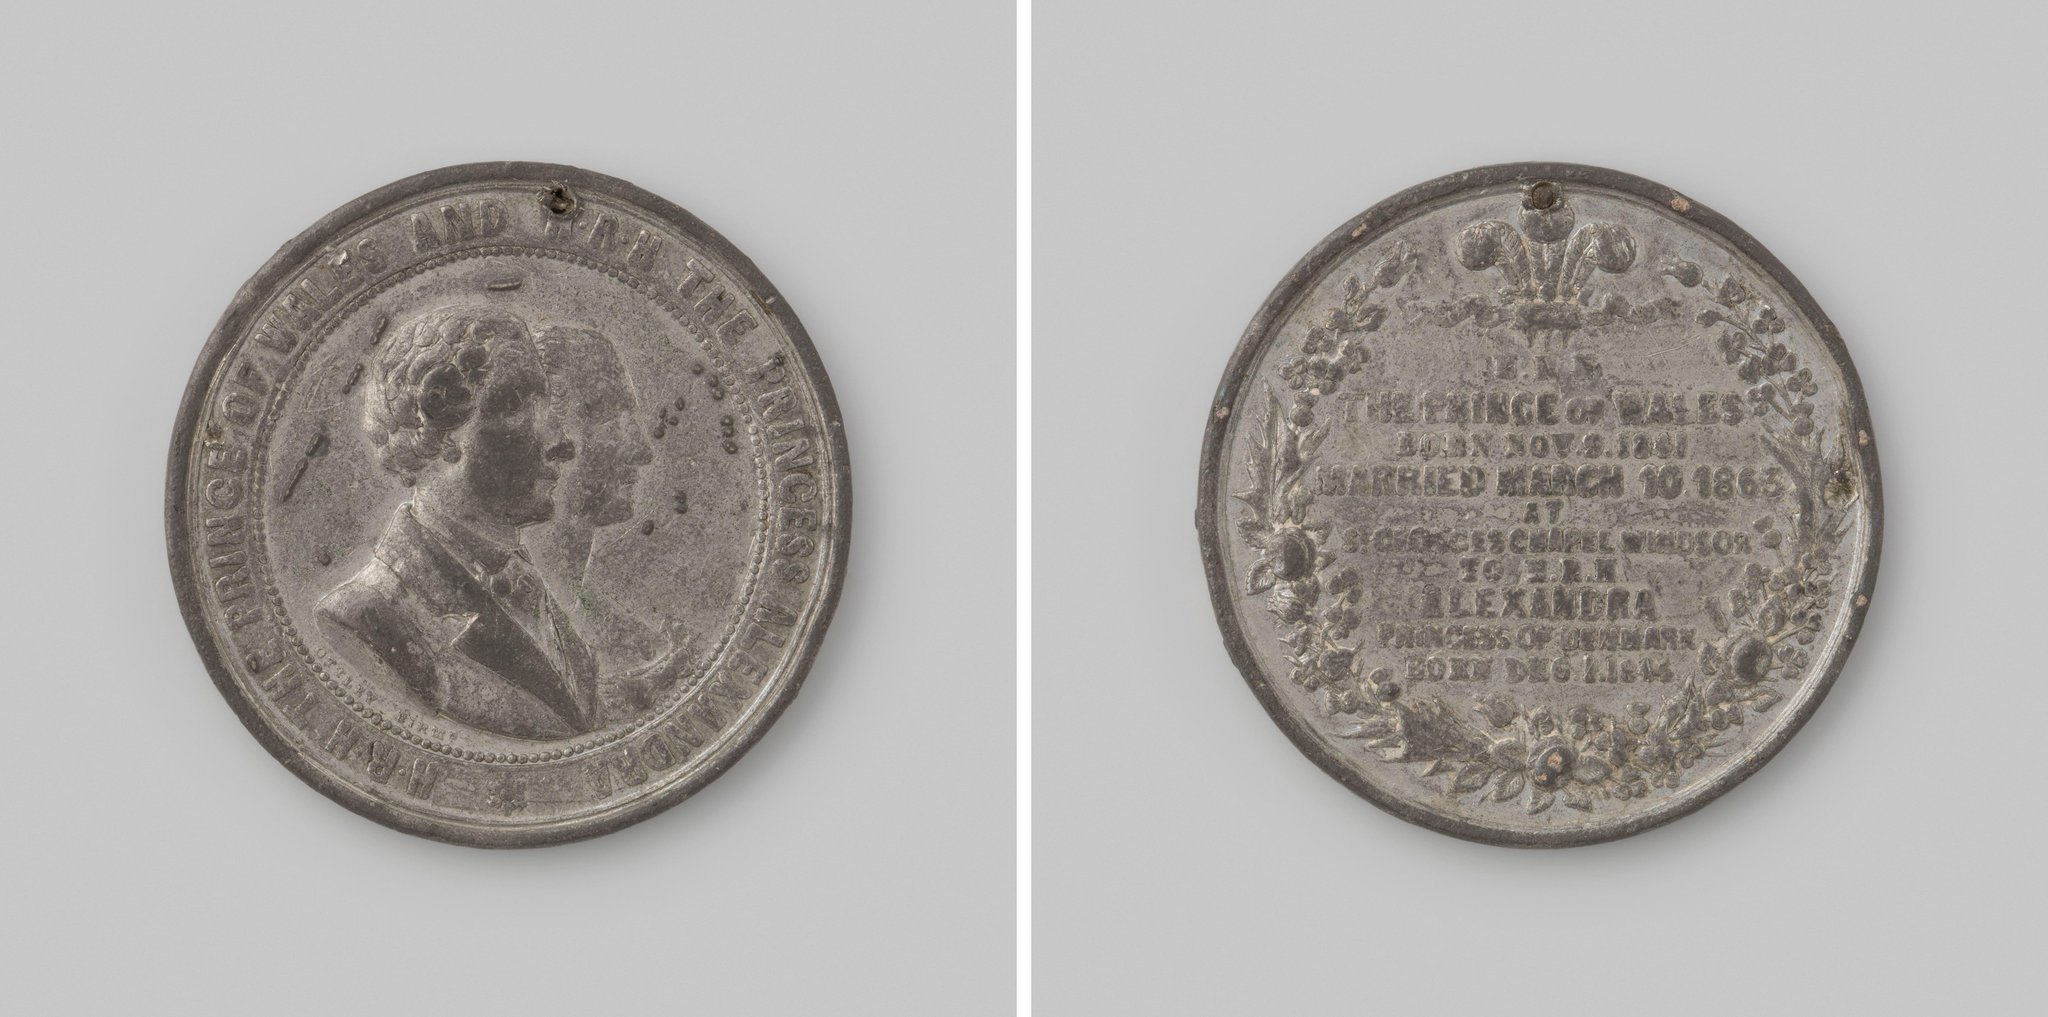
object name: history medal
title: Engelse penning op het huwelijk van de Prince of Wales met Alexandra van Denemarken 1863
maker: john ottley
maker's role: medailleur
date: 1863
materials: tin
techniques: striking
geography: birmingham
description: Tinnen penning met onvolledige doorboring, op de voorzijde de geconjugeerde borstbeelden van Albert en Alexandra naar rechts met omschrift, op de keerzijde tien regels tekst onder drie pauwenveren binnen een bloemenkrans.